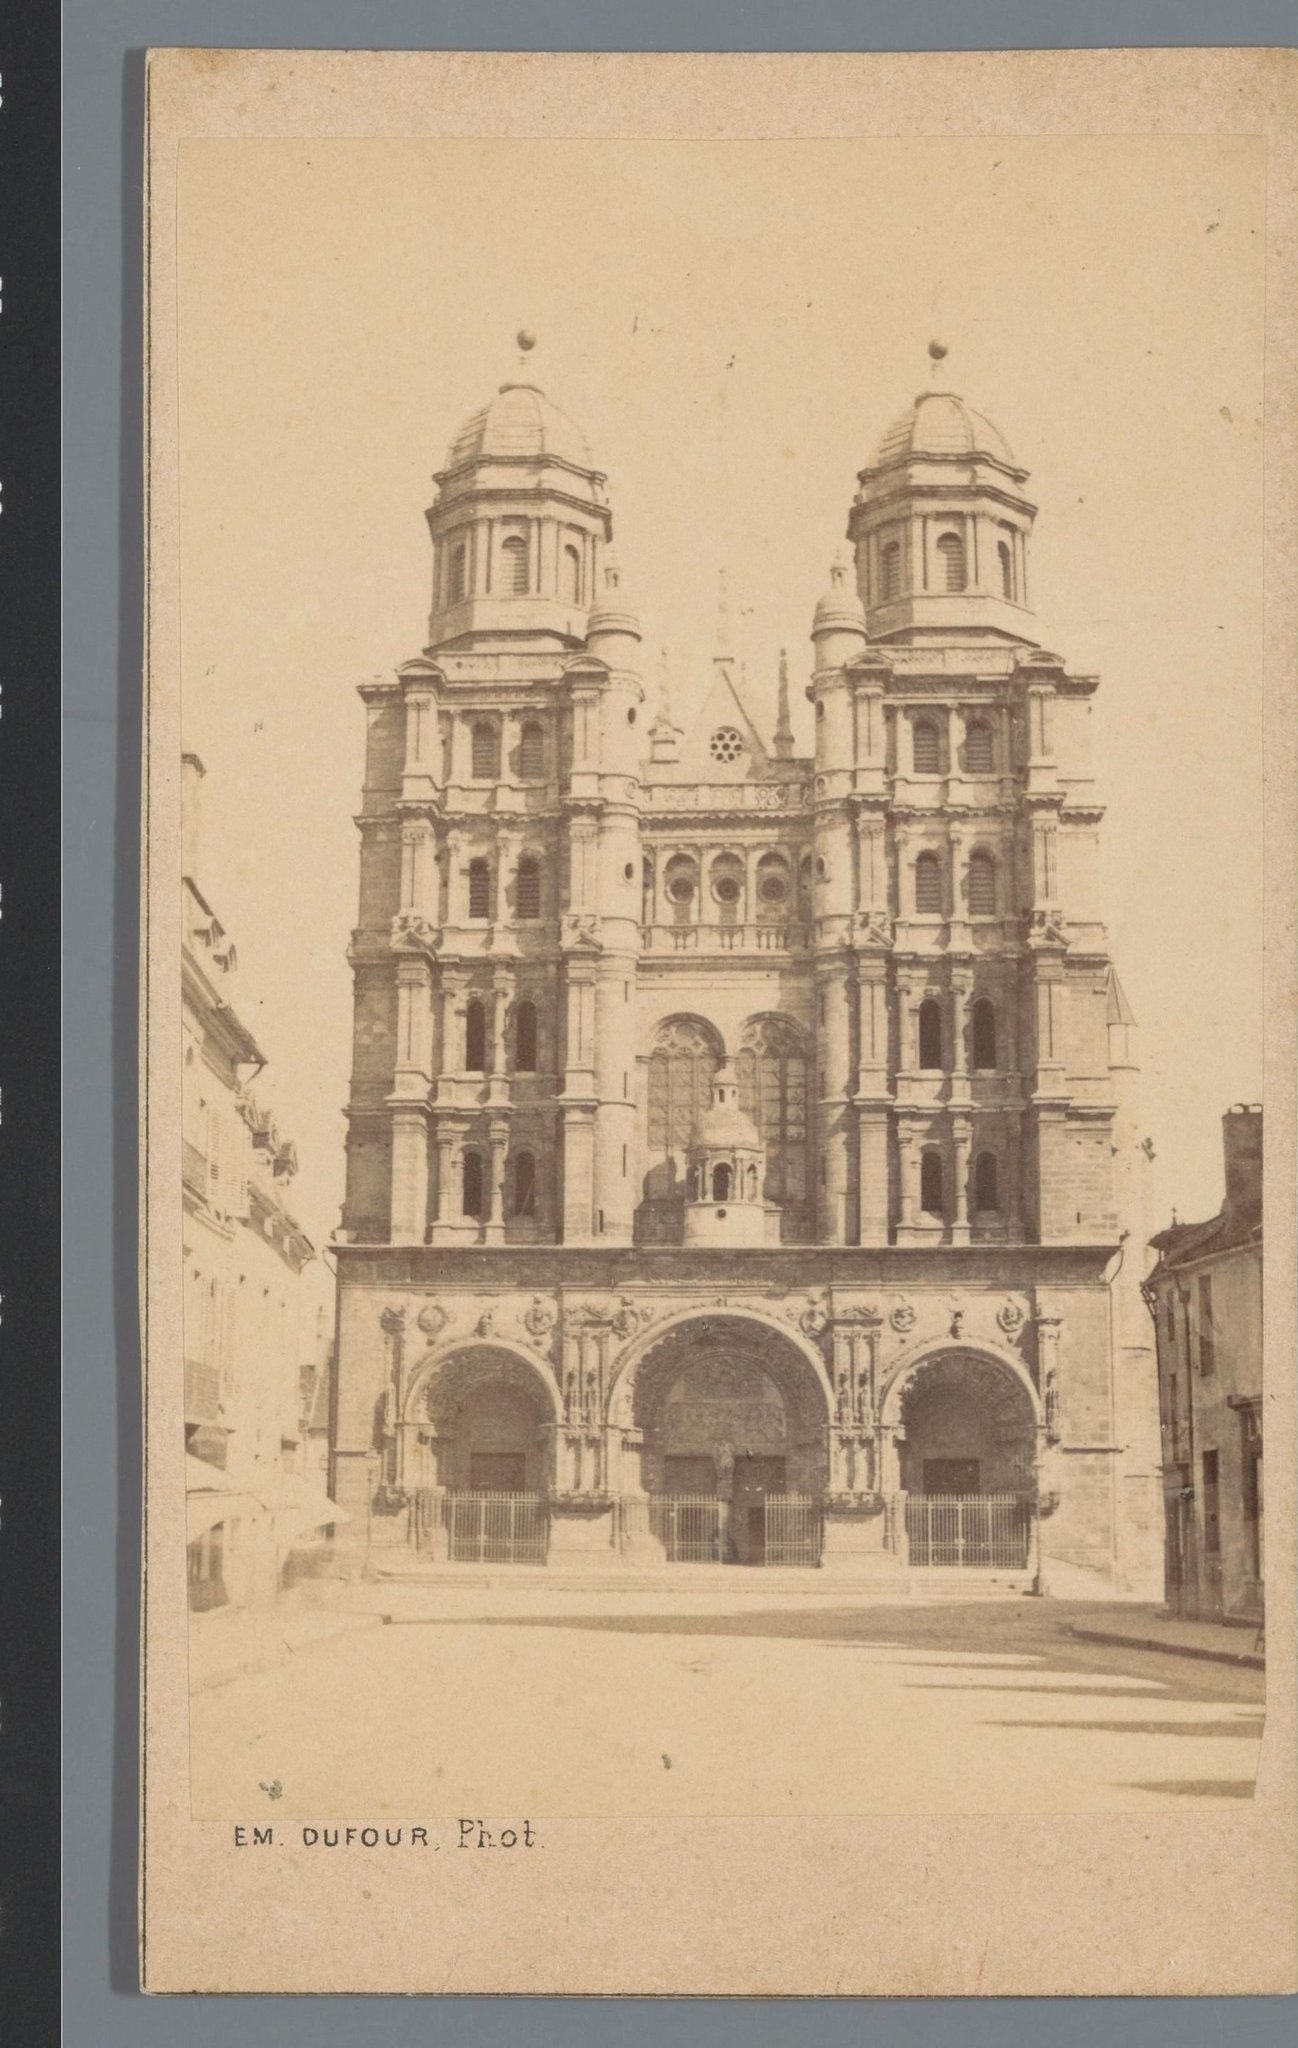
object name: photograph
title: Exterieur van de kerk van Saint Michel in Dijon, Frankrijk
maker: joseph emery-dufour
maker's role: fotograaf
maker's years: 1820-1869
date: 1855-1885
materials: cardboard, paper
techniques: albumen print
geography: dijon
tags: church (exterior)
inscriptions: inscription: ‘PHOTOGRAPHIE/ EM.- DUFOUR/ 6, Place Saint-Michel, 6/ DIJON.’